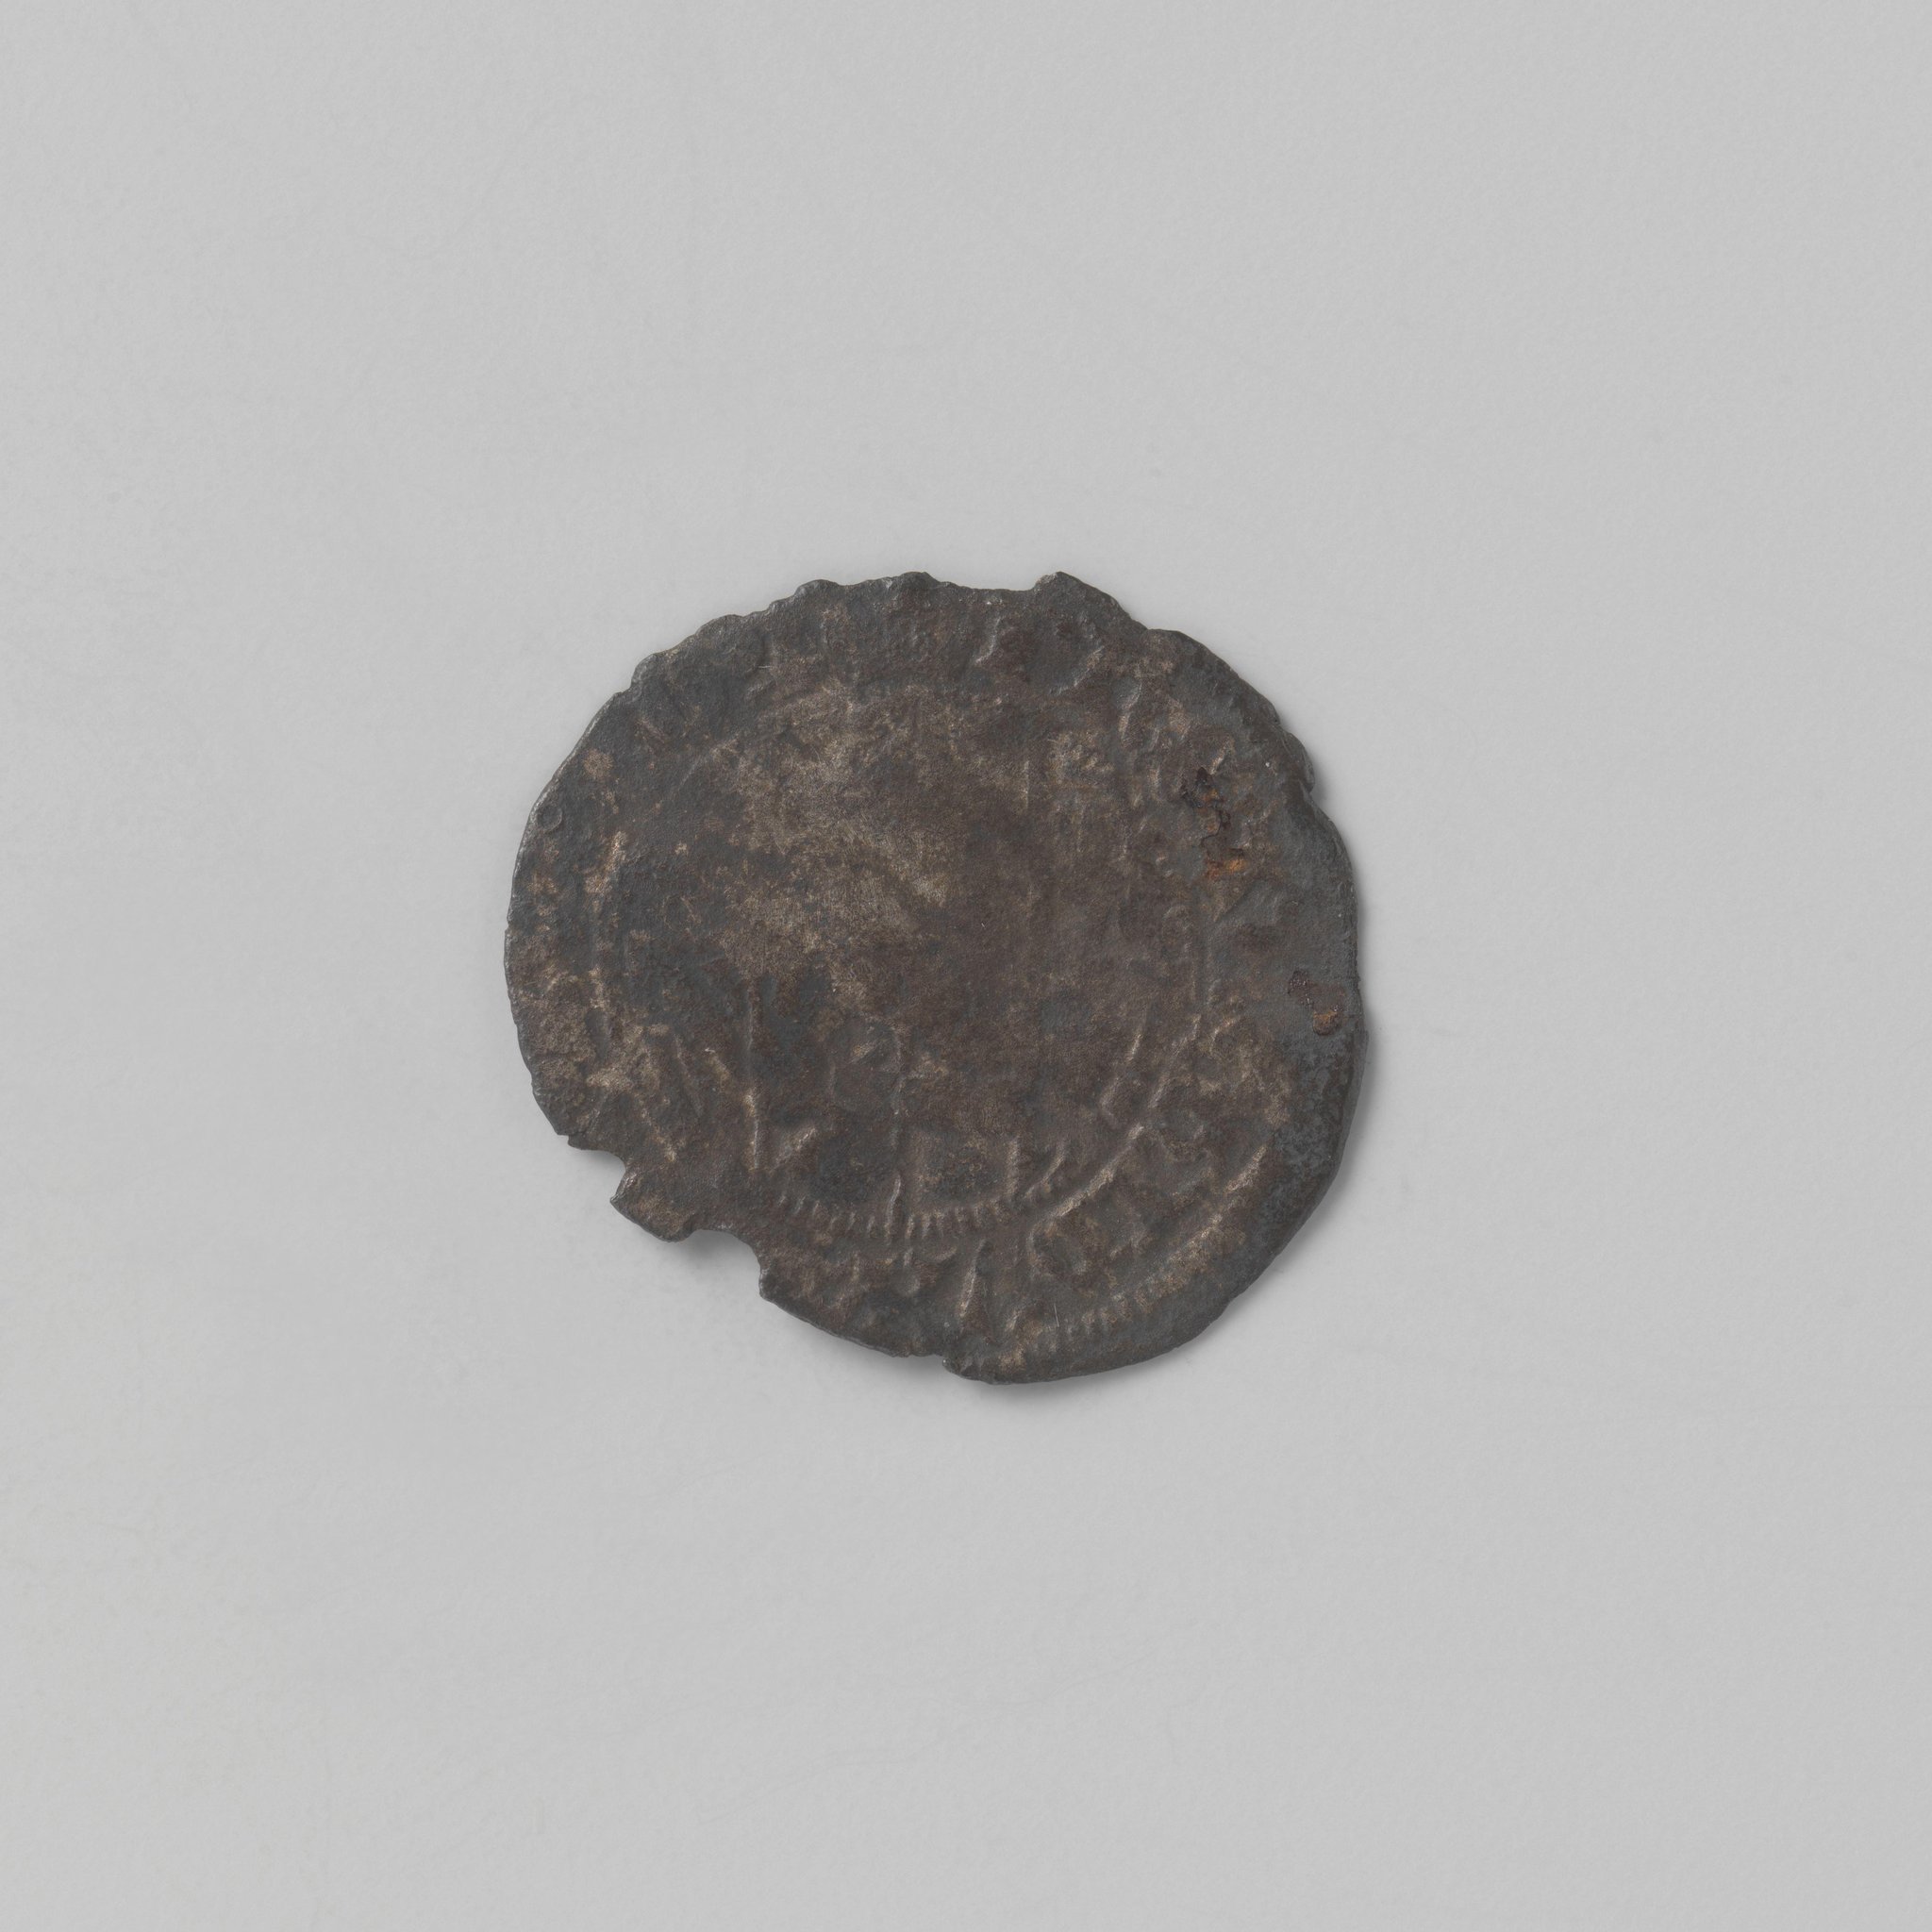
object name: coin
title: Holland, Philips de Schone, halve groot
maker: filips de schone (hertog van bourgondië)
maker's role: aartshertog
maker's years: 1478-1506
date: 1493-1496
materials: silver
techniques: striking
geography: dordrecht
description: Zilveren munt. Voorzijde: wapen van Oostenrijk-Bourgondië in veld. Keerzijde: lang gevoet kruis, in hoeken afwisselend leeuwtjes en roosjes.